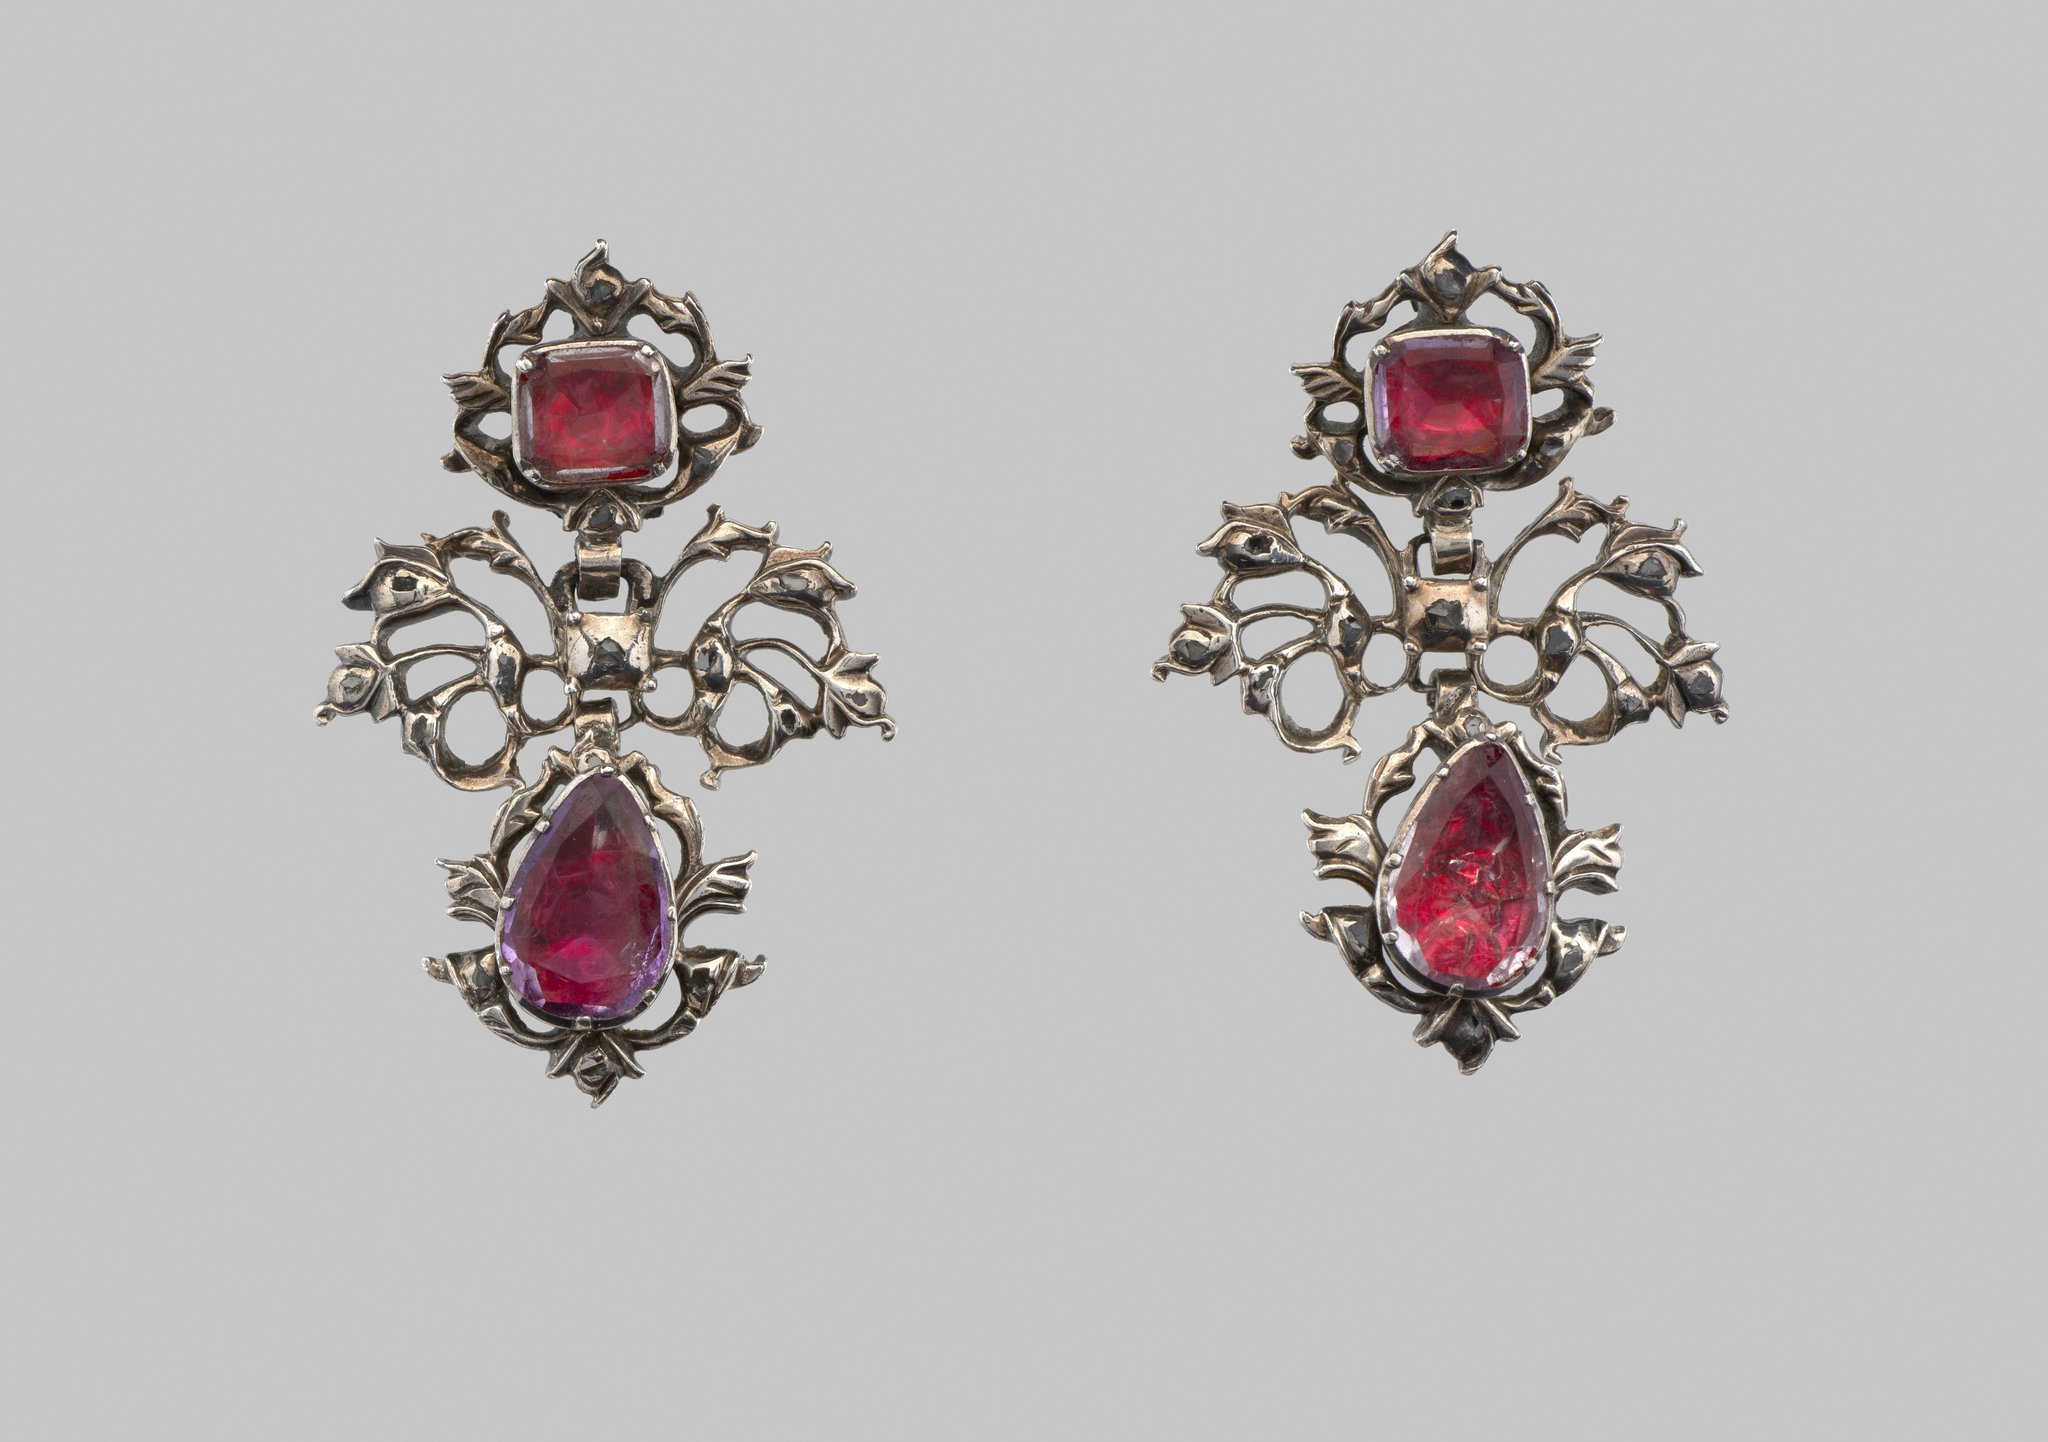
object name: earring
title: Pair of earrings (part of a set)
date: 1701-1800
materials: silver